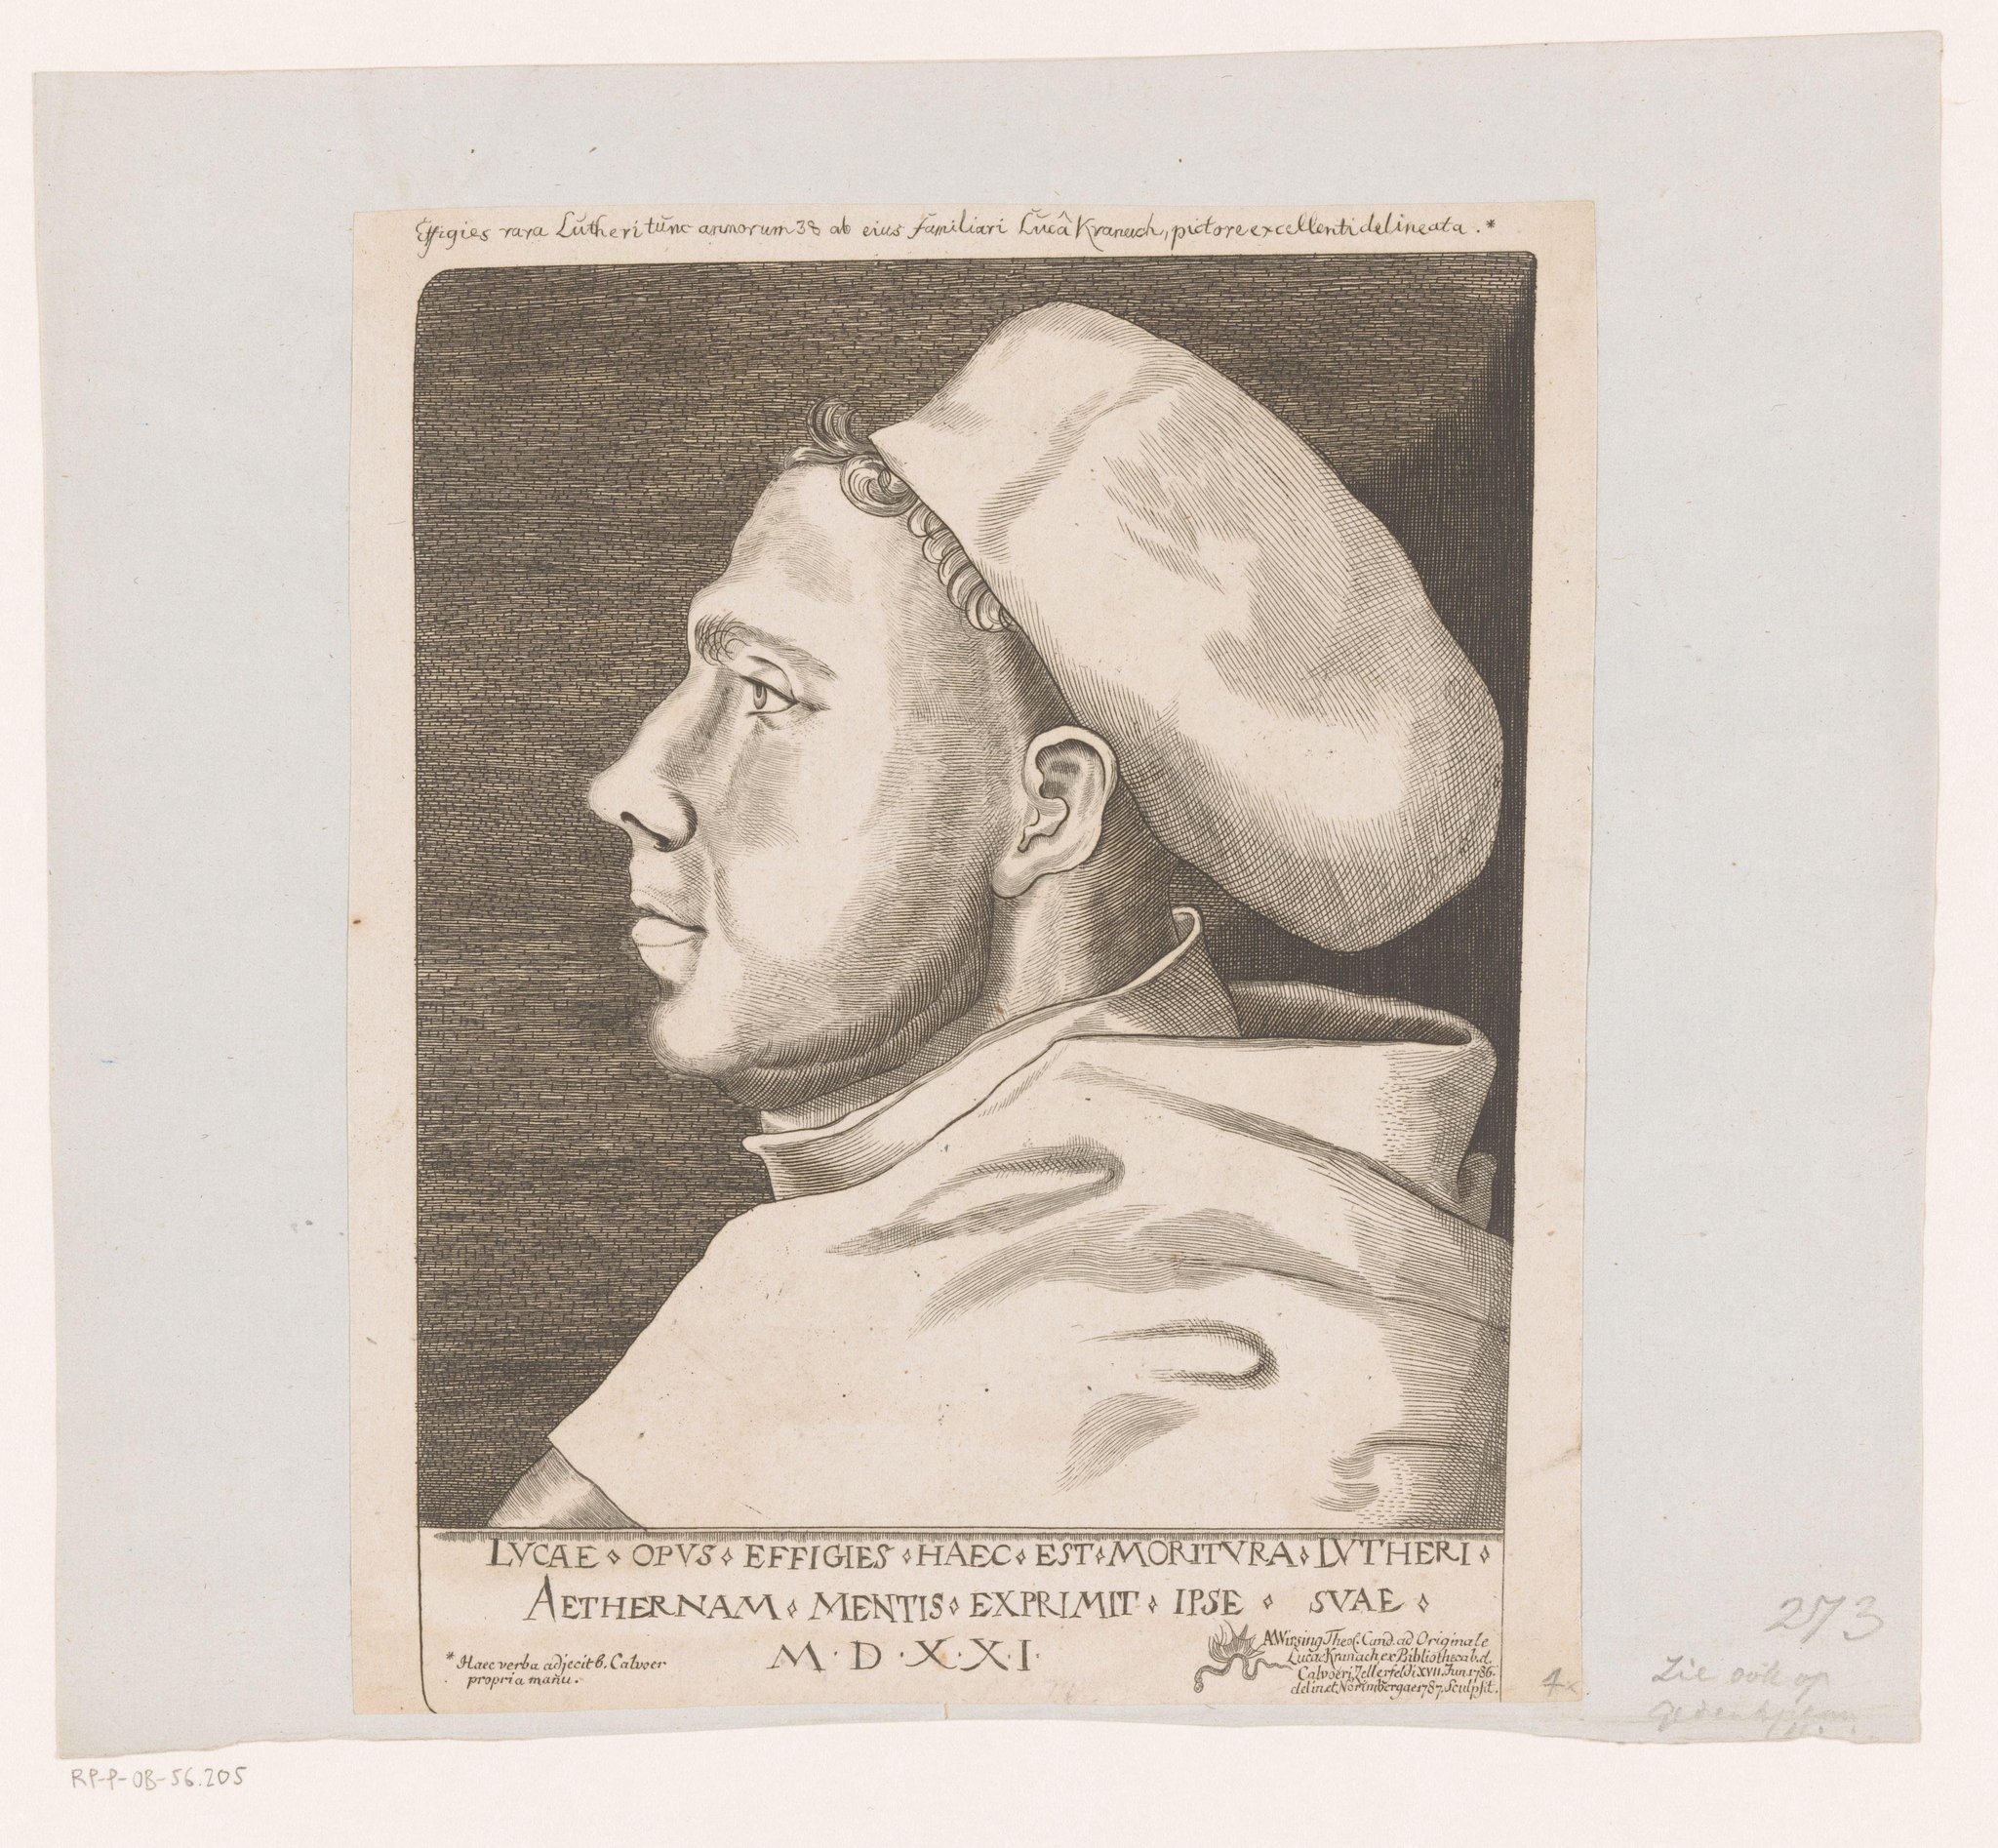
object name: print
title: Portret van Martin Luther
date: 1787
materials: paper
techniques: engraving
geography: nuremberg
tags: priest, martin luther, historical persons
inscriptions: date